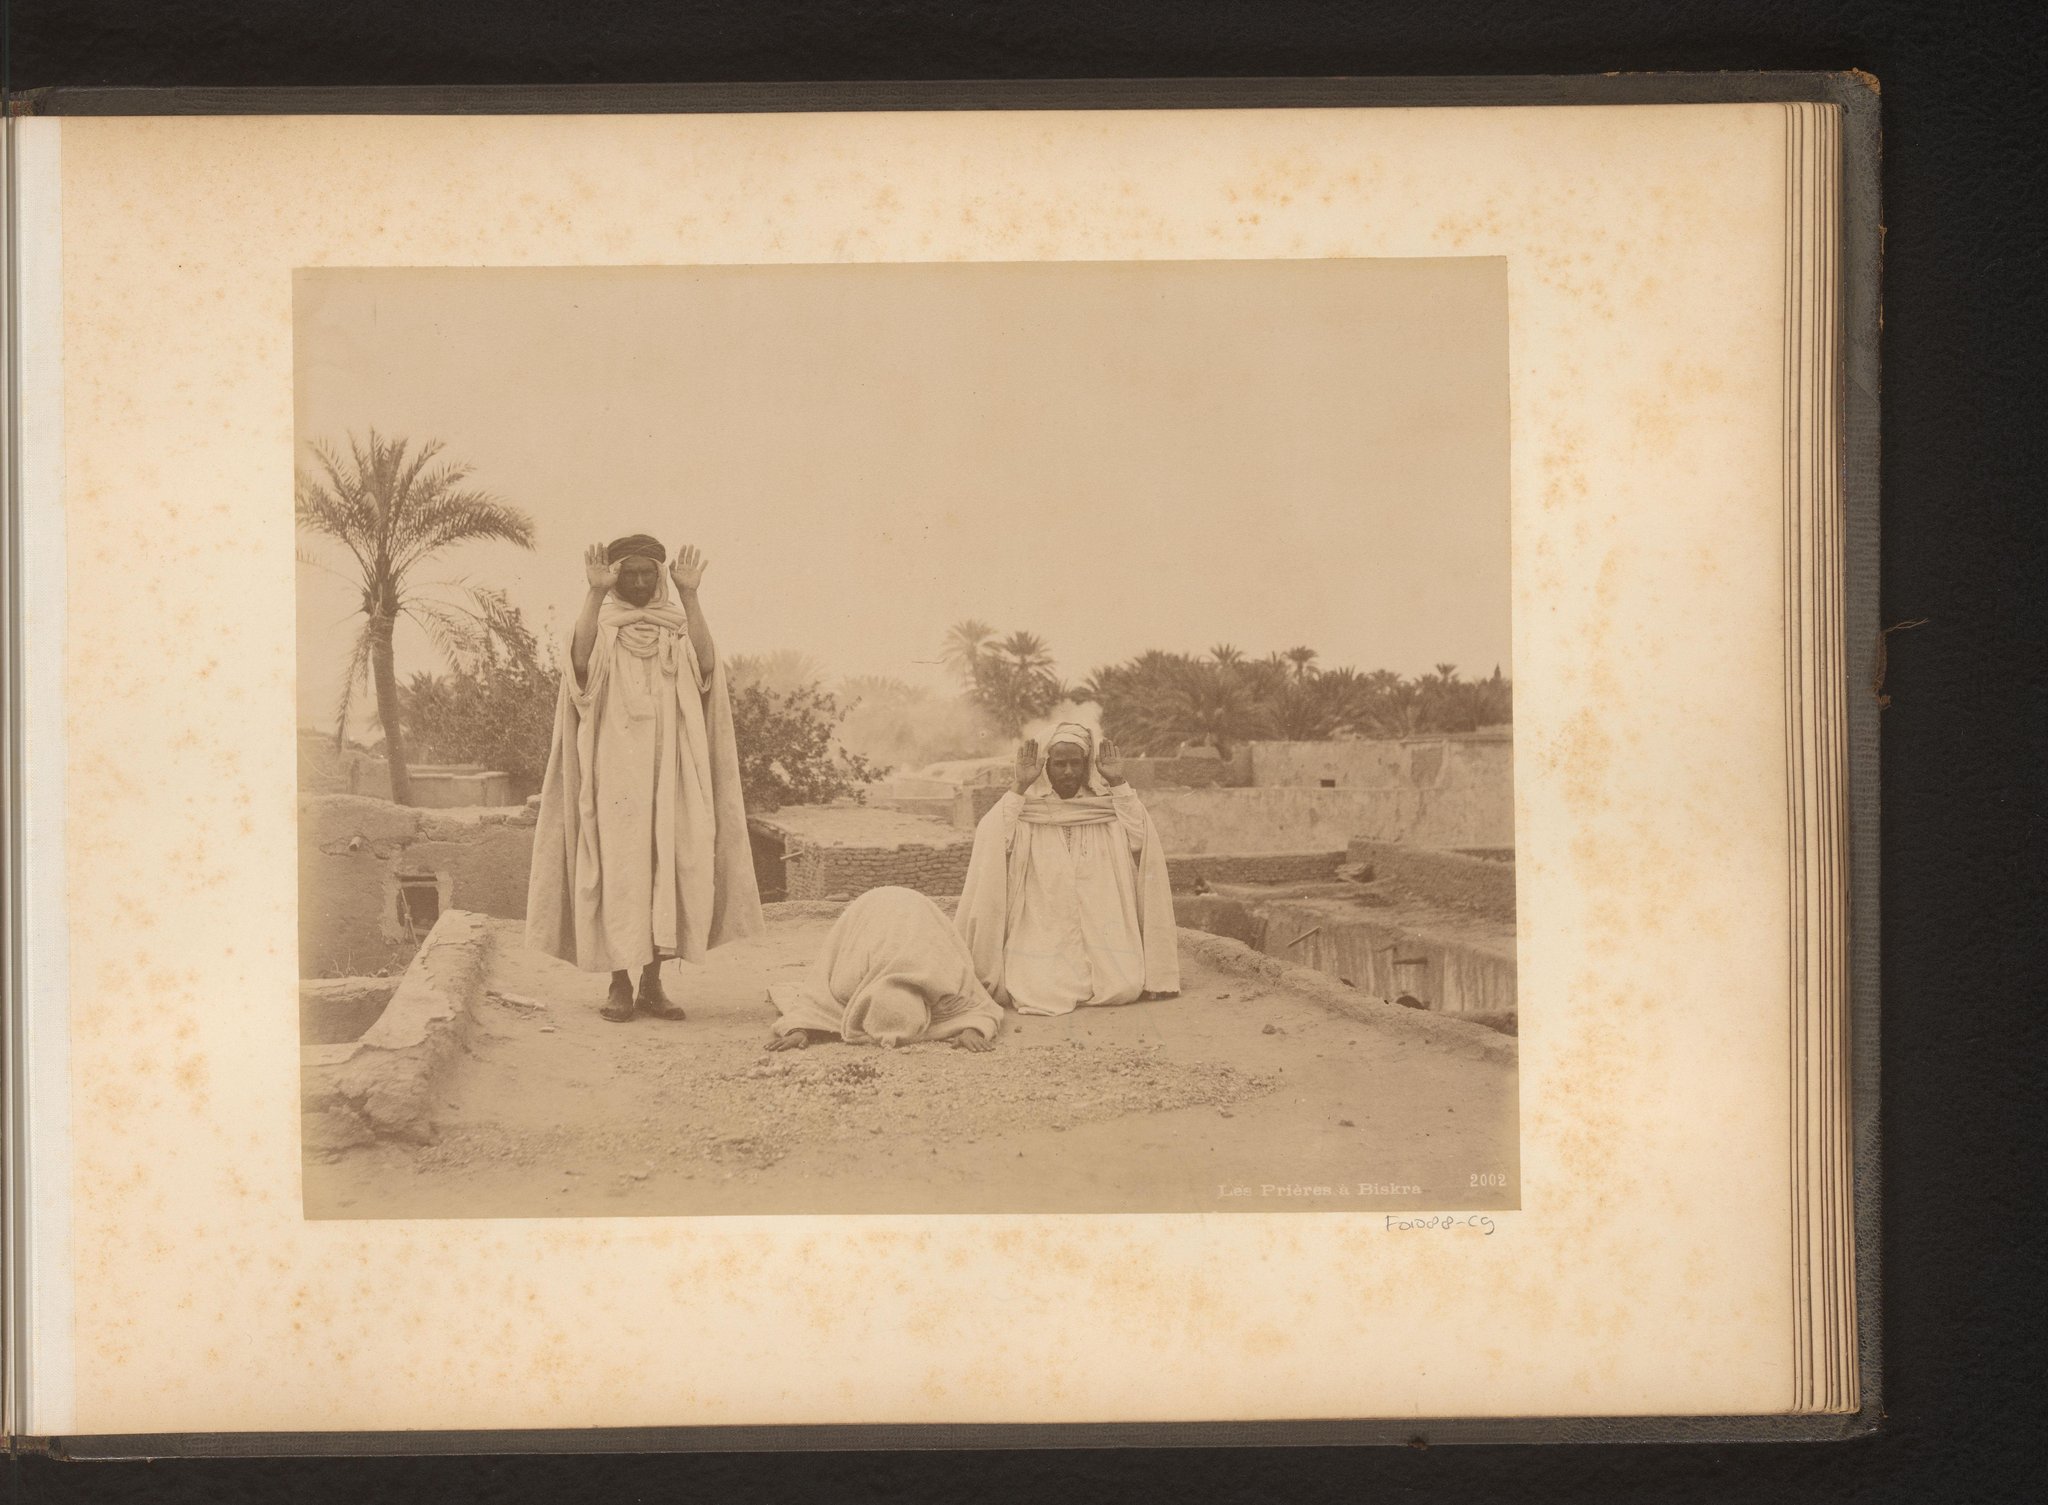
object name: photograph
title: Biddende mannen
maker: Anonymous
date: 1880-1900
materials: photographic support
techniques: albumen print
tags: adult man, historical persons, prayer ~ islam, mohammedanism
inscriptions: number: ‘2002’